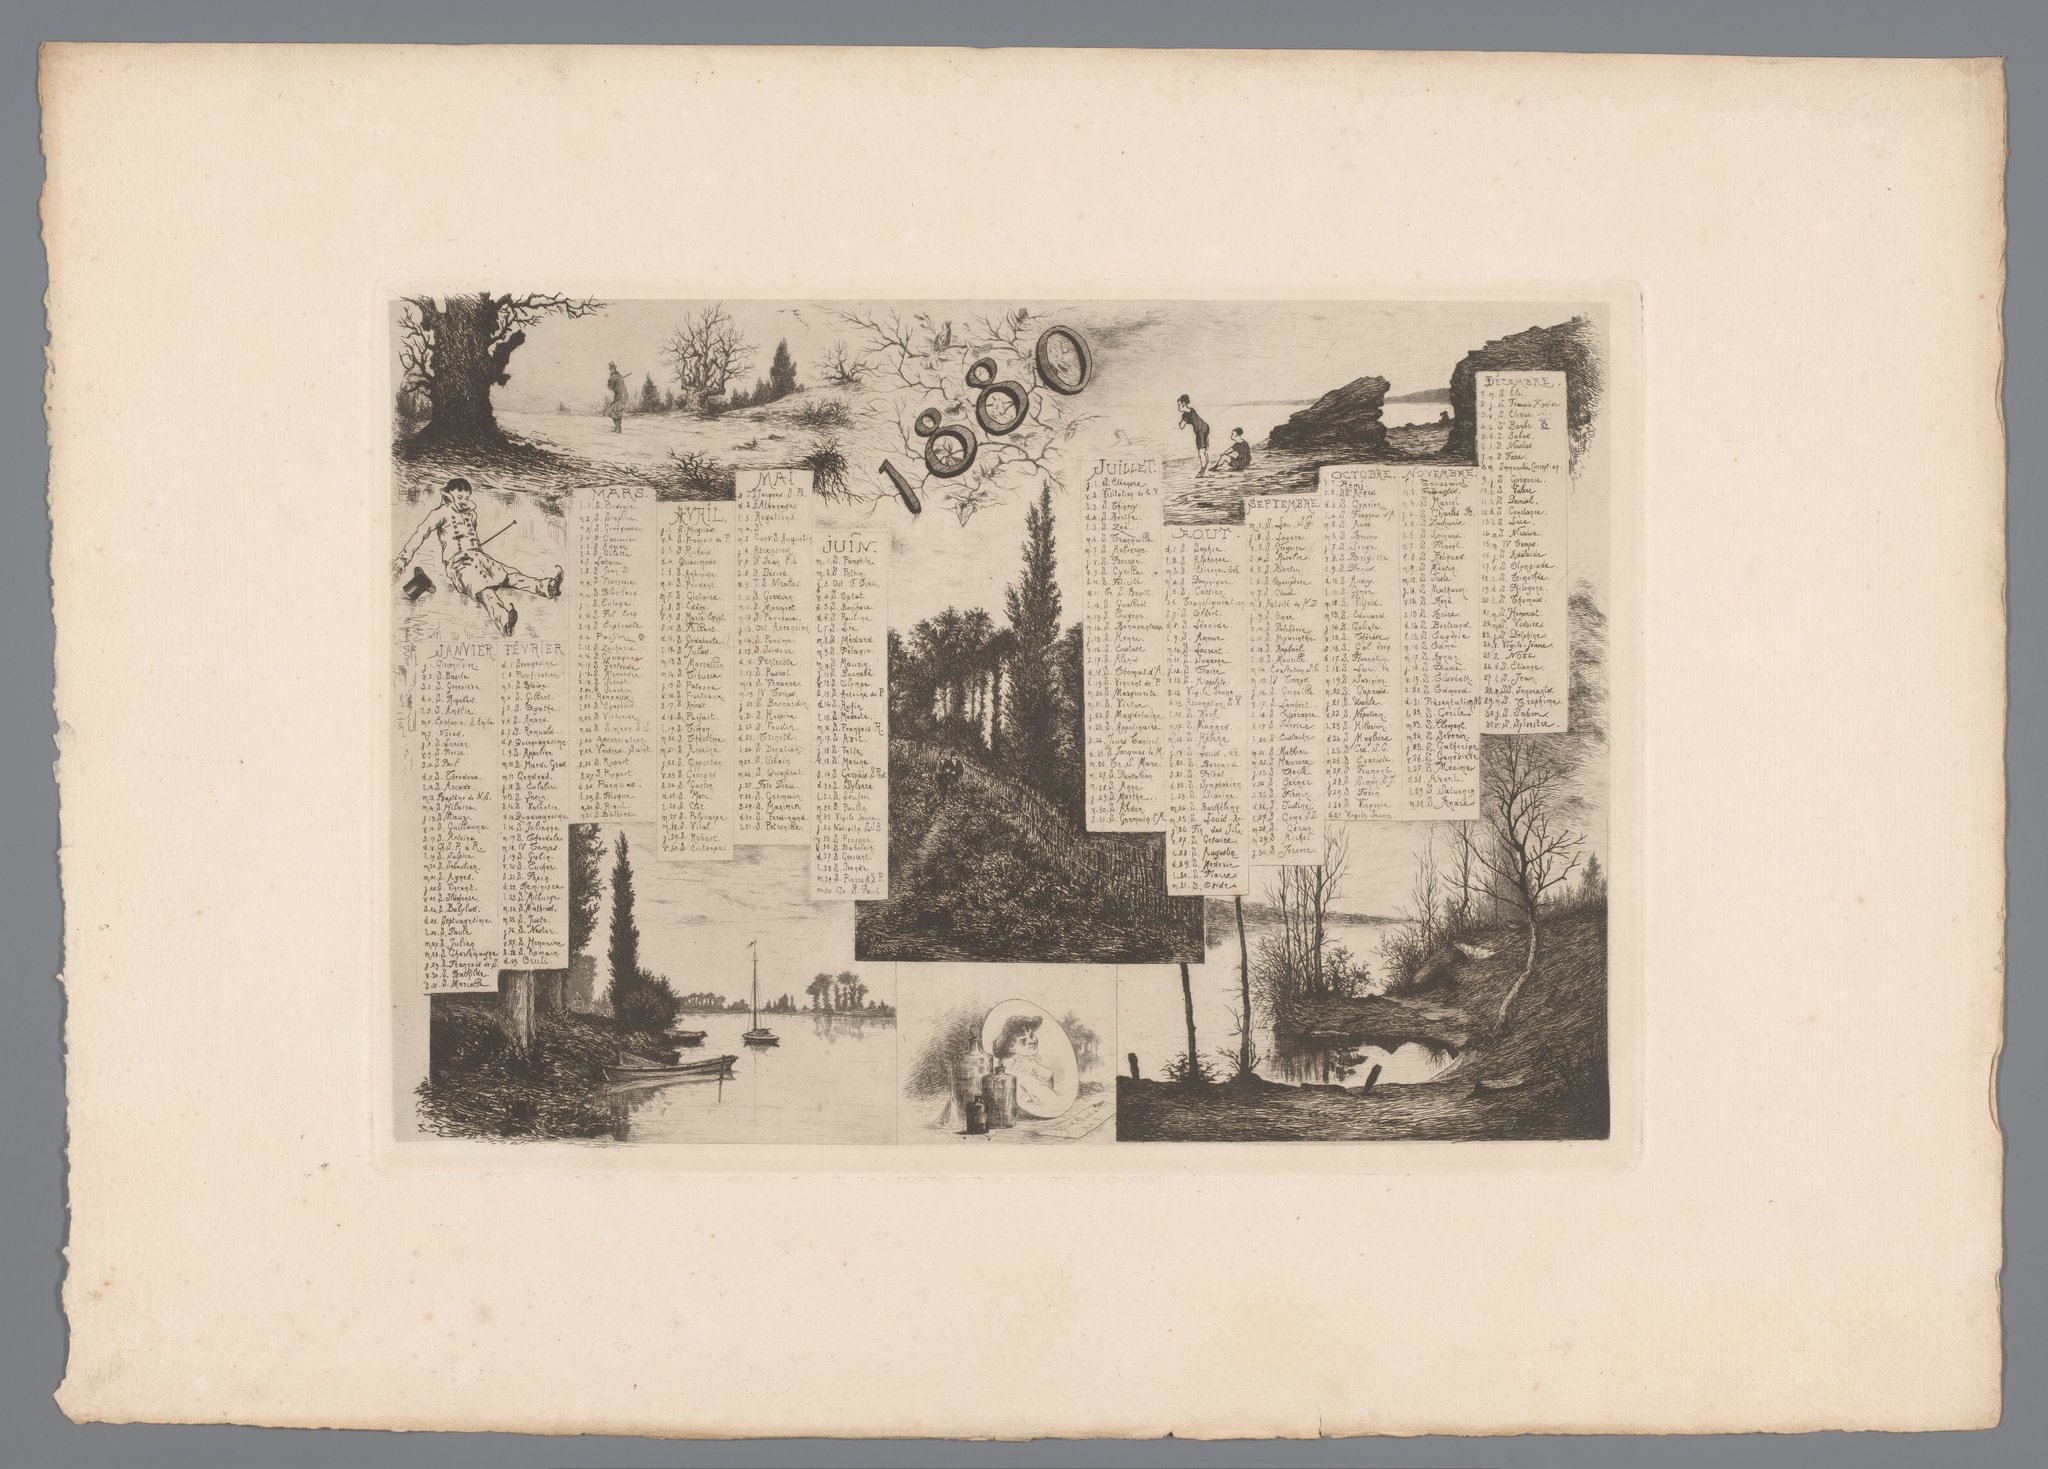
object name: print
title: Kalender voor het jaar 1880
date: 1880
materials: paper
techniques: drypoint, etching, intaglio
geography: paris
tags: calendar, almanac, landscapes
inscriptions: collector's mark: ‘AFE v S’, collector's mark: Lugt 2760, collector's mark: Lugt 2228, watermark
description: Overzicht van de maanden omringd door landschappen.